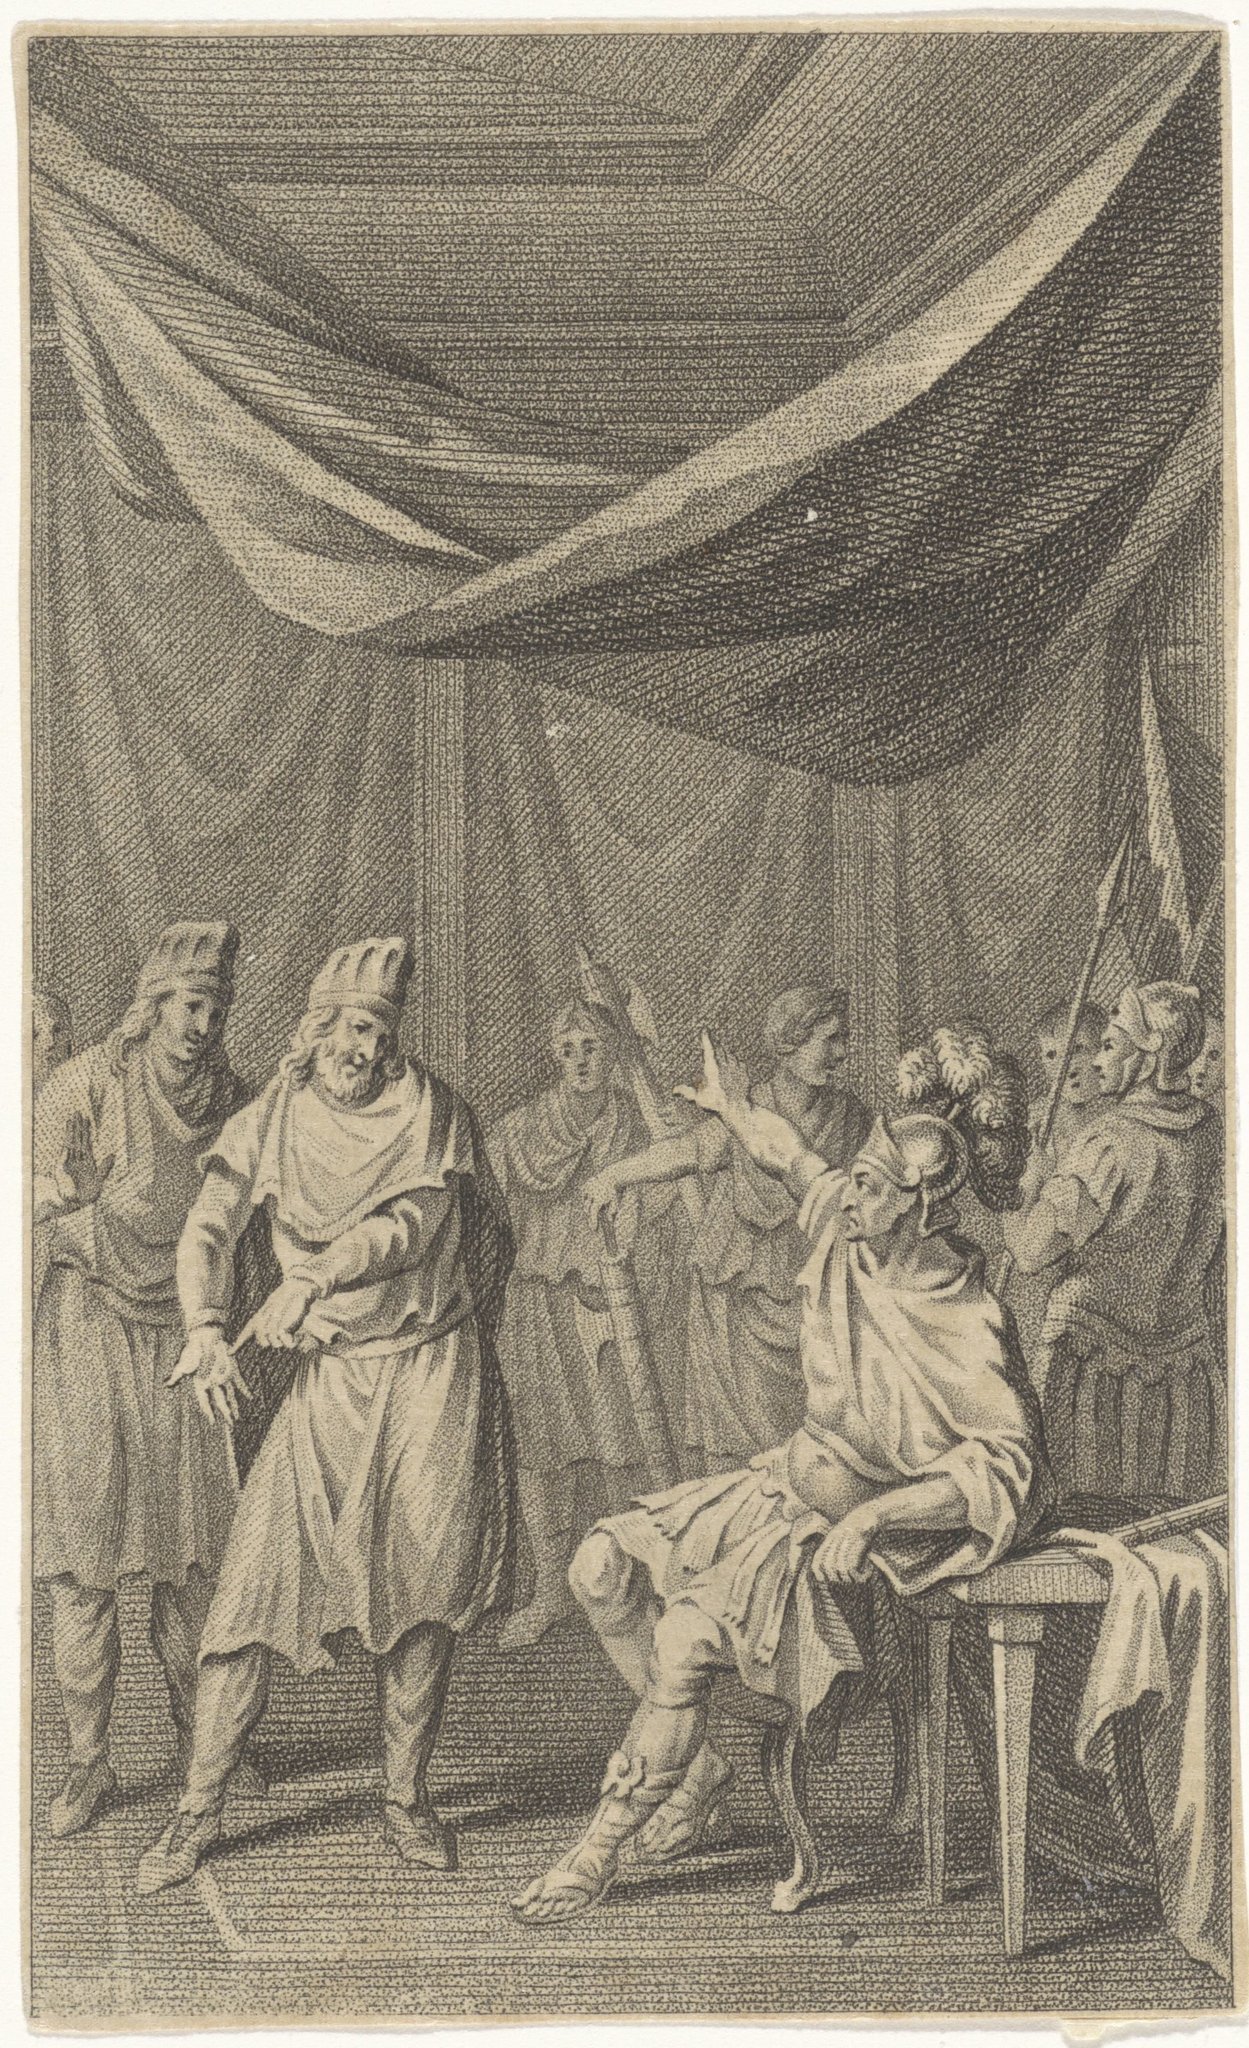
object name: print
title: Marcus Licinius Crassus uitgelachen door Parthische afgezanten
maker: ludwig gottlieb portman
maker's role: print maker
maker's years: 1772-1828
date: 1800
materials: paper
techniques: etching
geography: amsterdam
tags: (story of) m. licinius crassus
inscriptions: collector's mark: Lugt 2228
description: De Parthische veldheer Vagises wijst op de binnenkant van zijn hand. Hij zegt tegen Marcus Licinius Crassus dat er nog sneller haar op zijn hand zal groeien dan dat Crassus Seleucia zal bereiken.